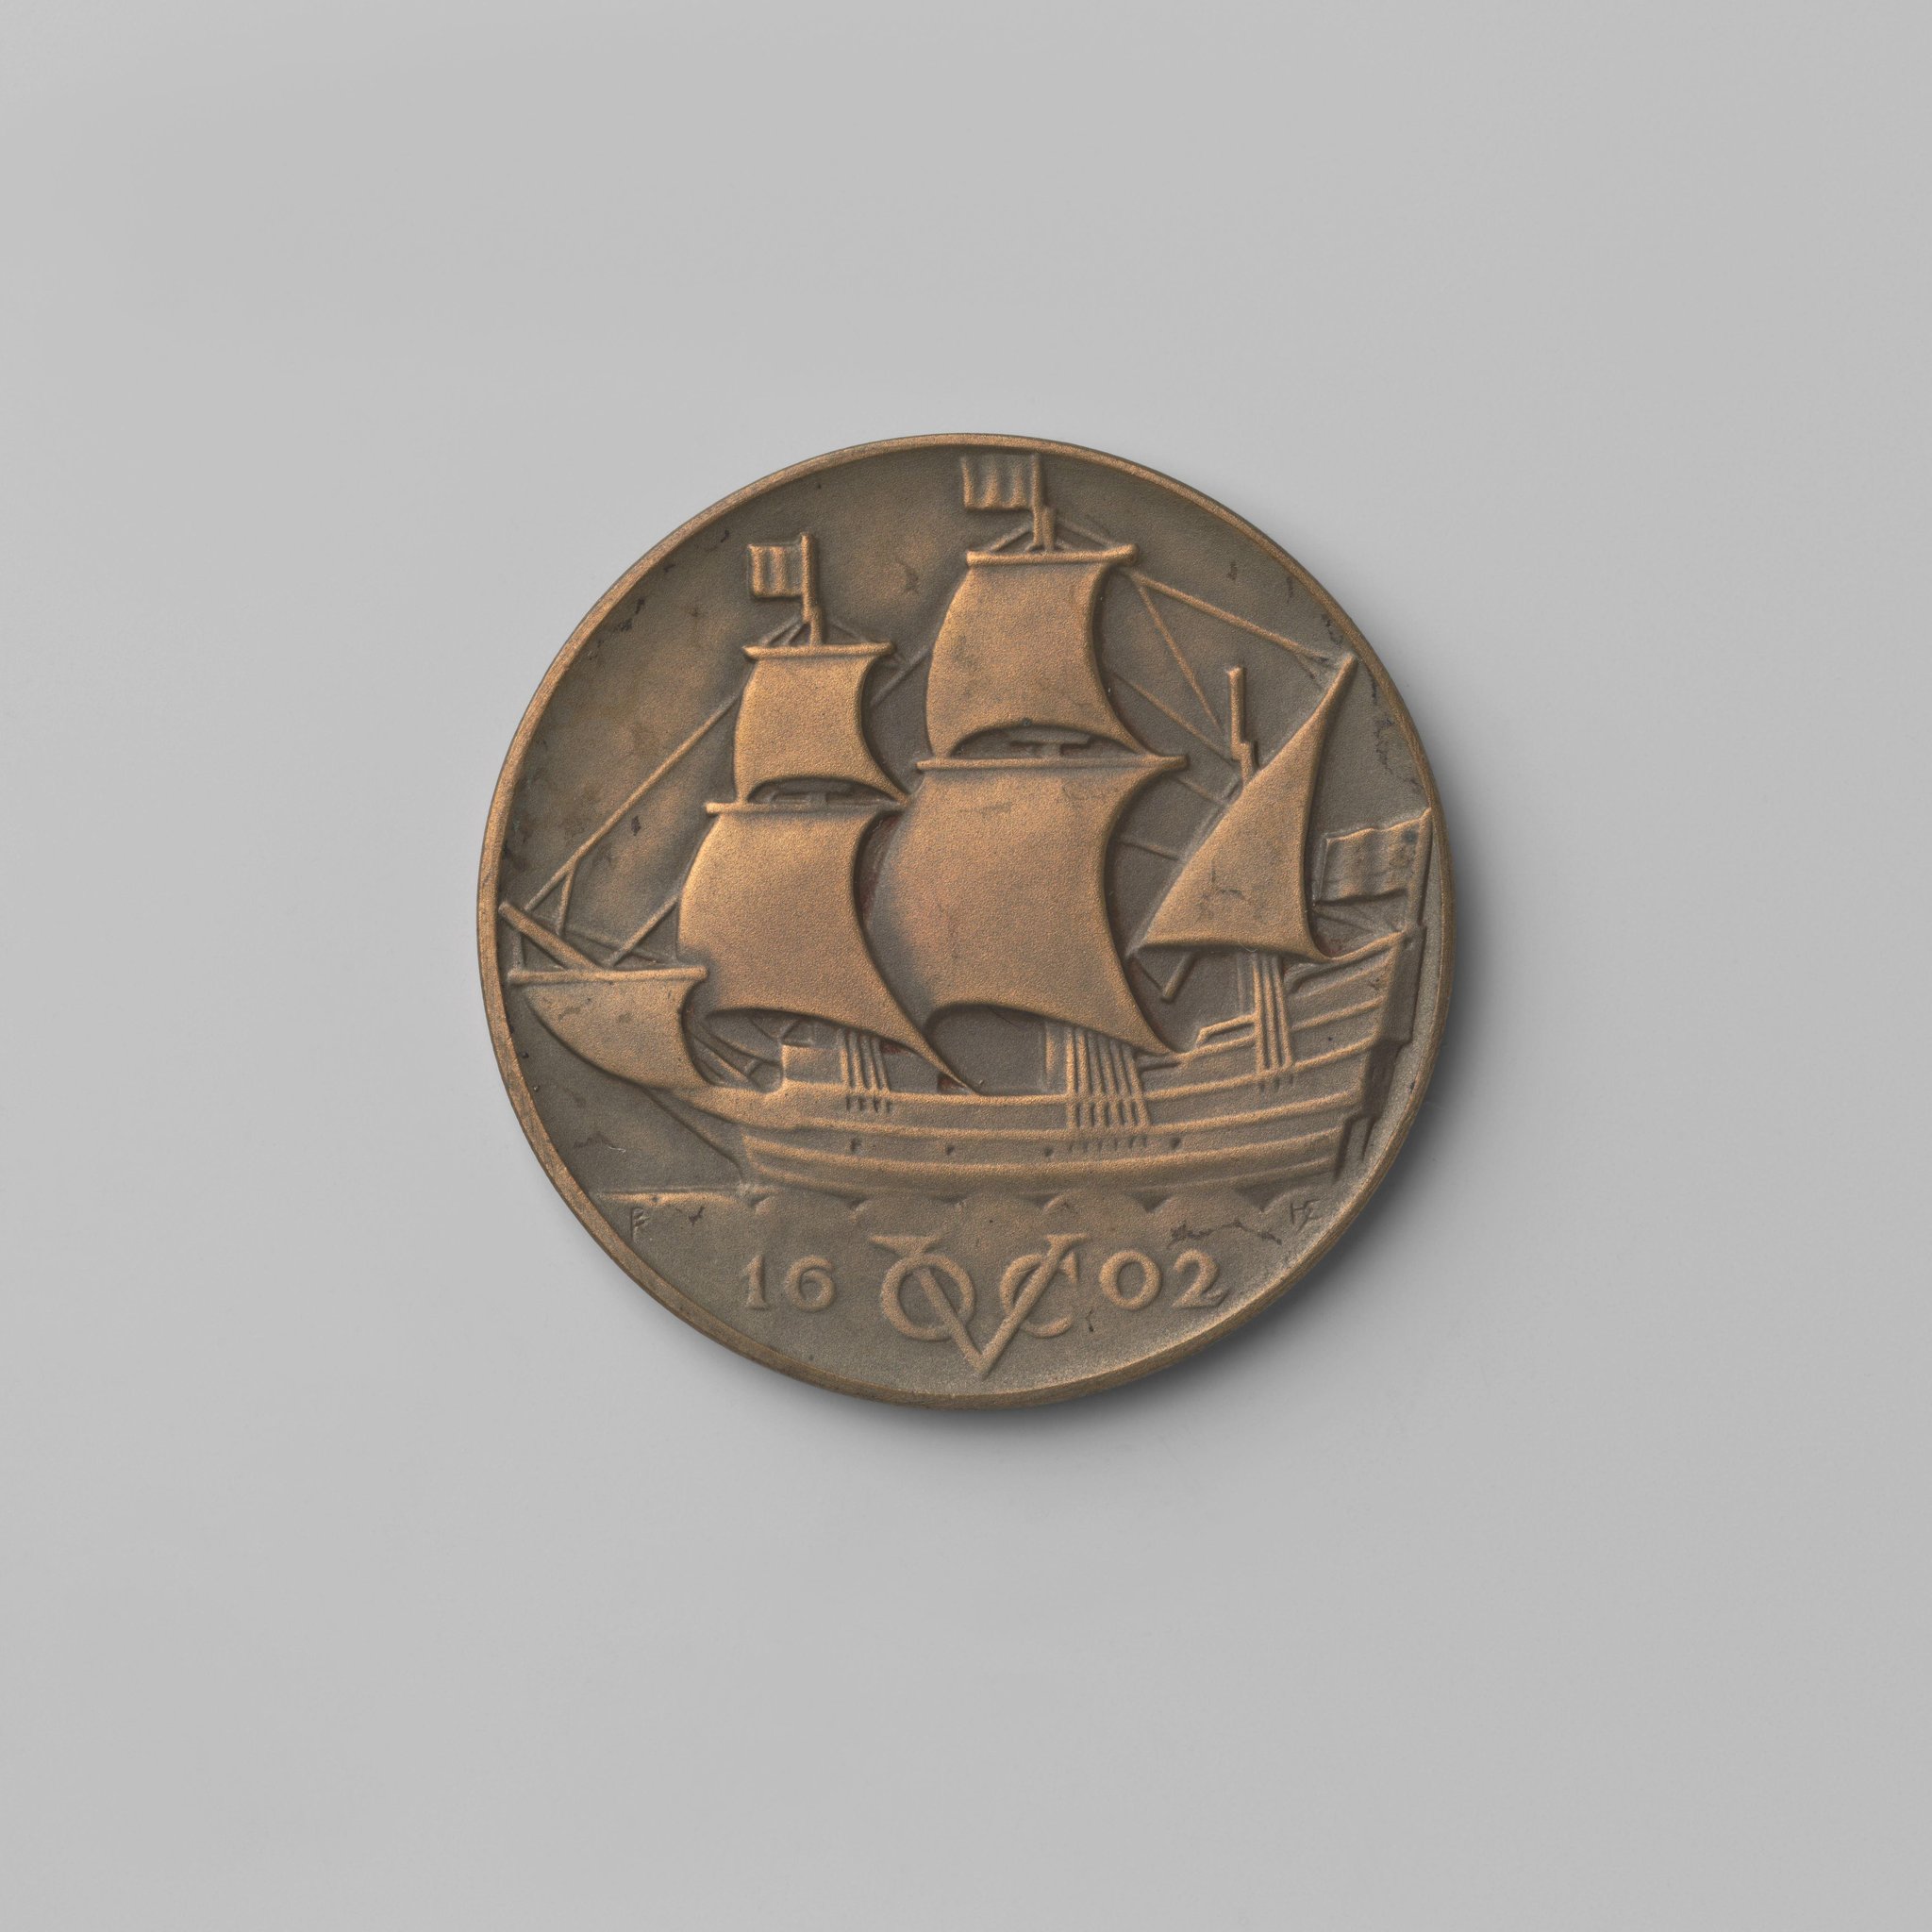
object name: history medal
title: De verbinding tussen Nederland en Indië toen en nu (Vereniging voor Penningkunst 1928, tweede penning)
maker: henk etienne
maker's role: sculptor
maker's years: 1895-1968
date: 1928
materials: bronze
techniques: striking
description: Bronzen penning, op de voorzijde een driemaster zeilend naar links met in afsnede het VOC-monogram tussen 16 en 02, op de keerzijde een vliegtuig vliegend naar links met in afsnede het KLM-embleem tussen 19 en 28, met verklaring.